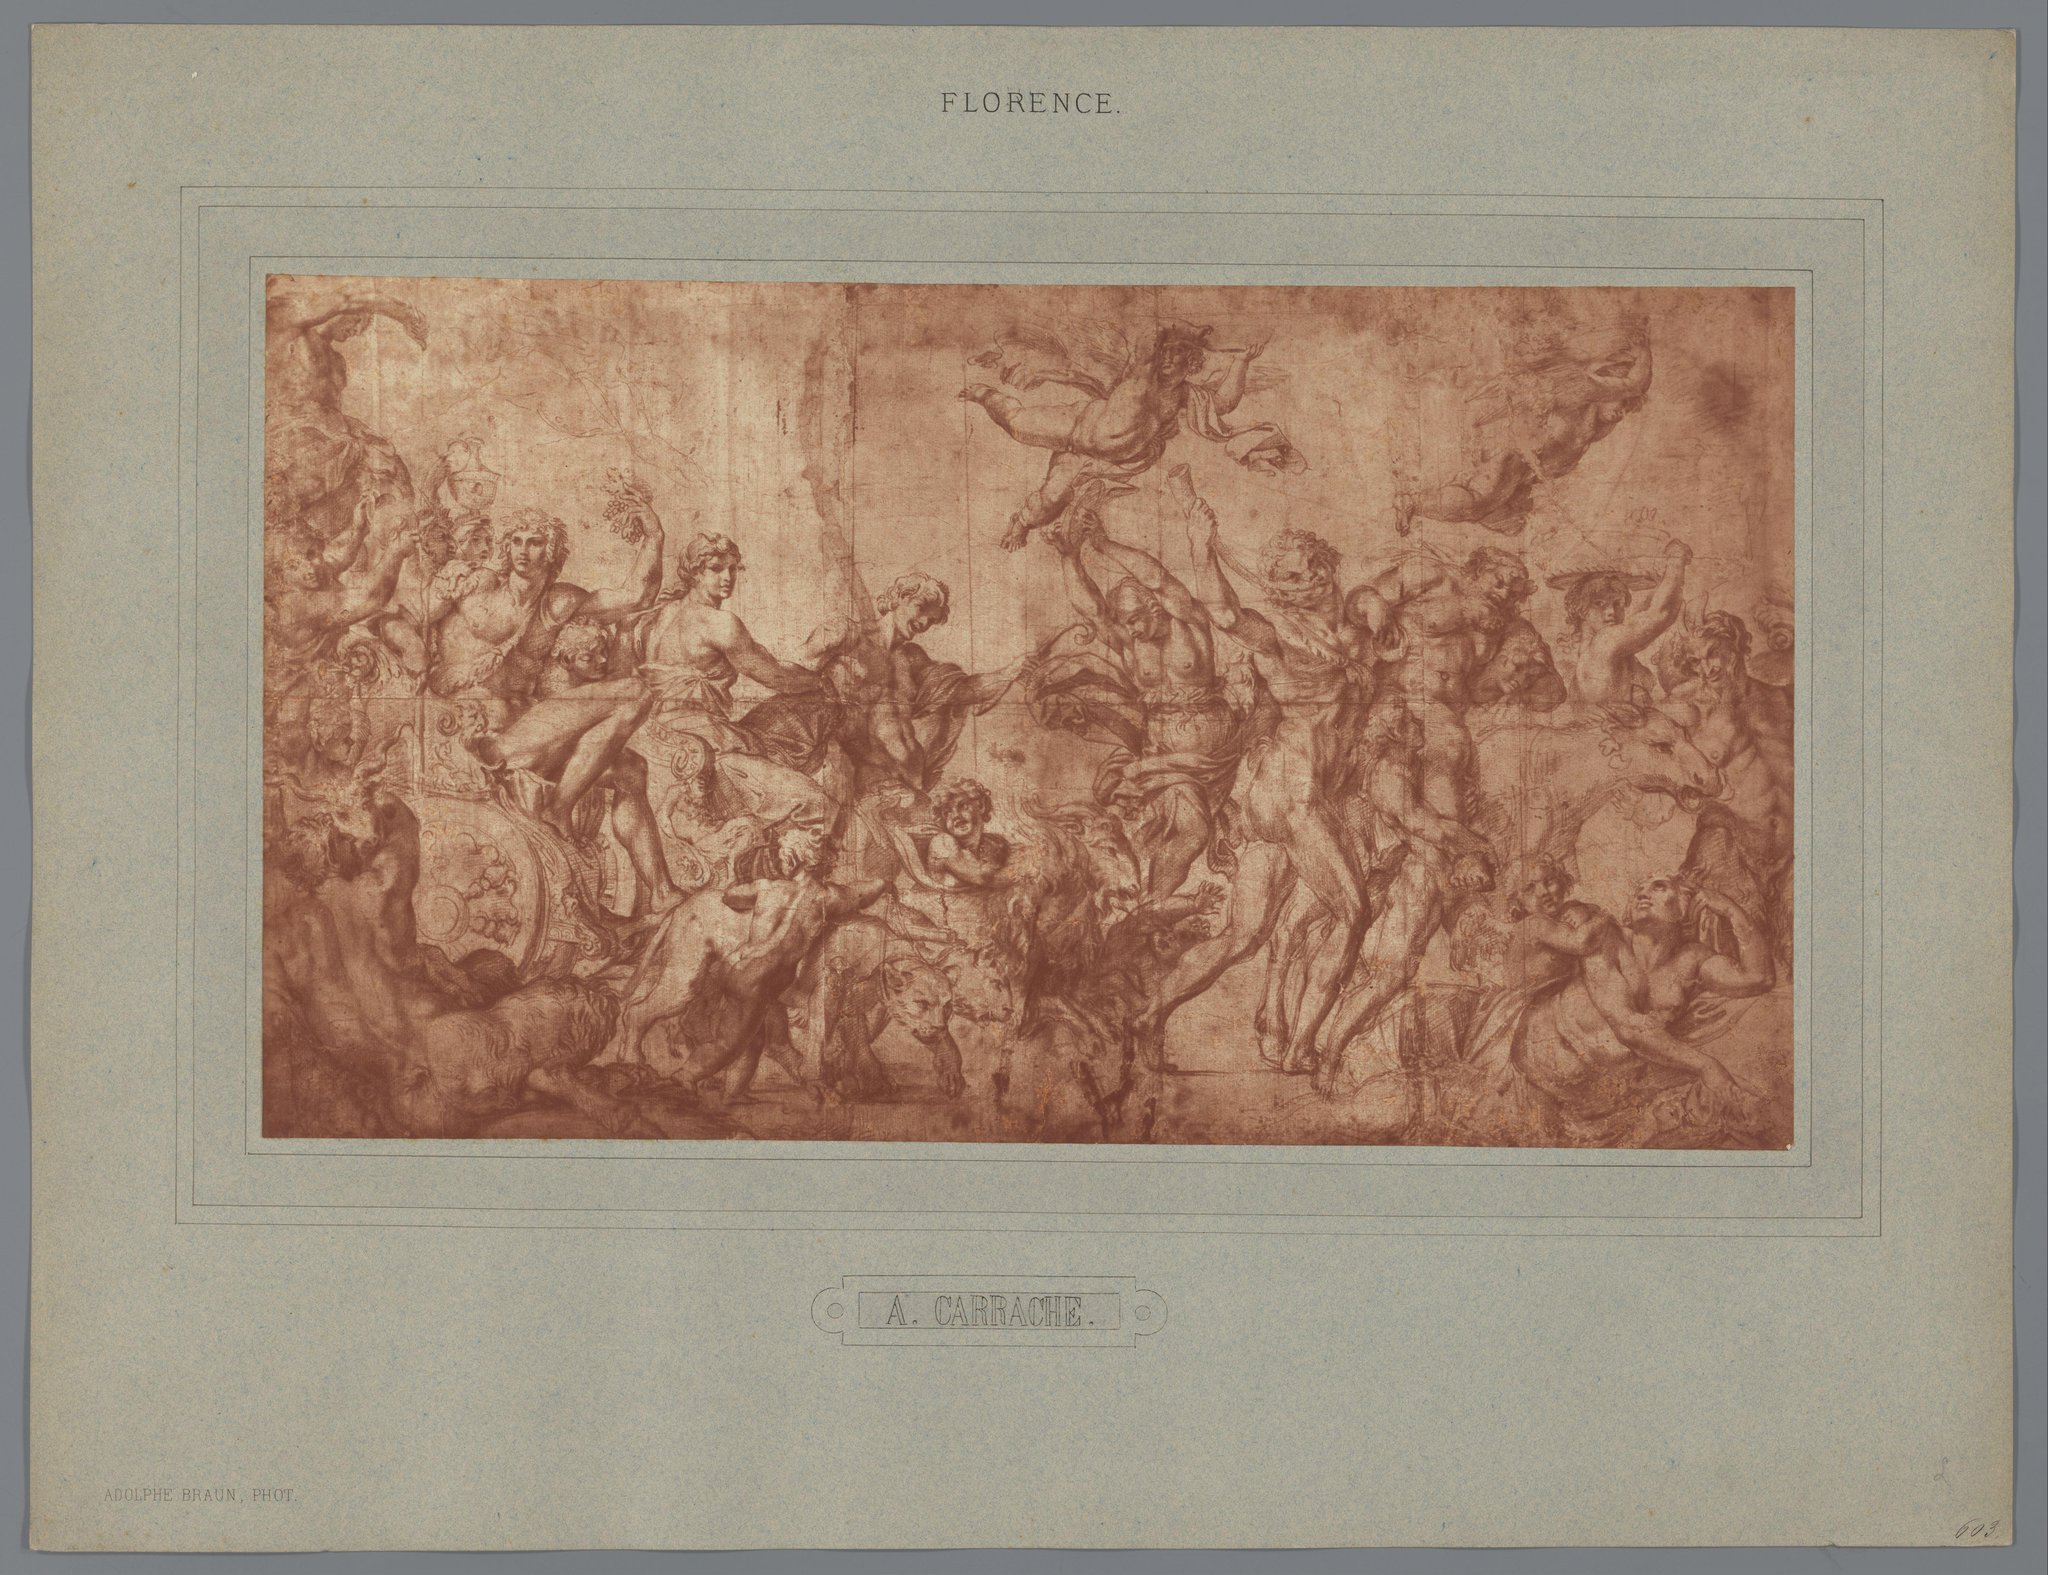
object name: photograph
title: Fotoreproductie van een tekening van Annibale Caracci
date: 1880-1900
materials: cardboard, paper, photographic support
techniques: carbon print